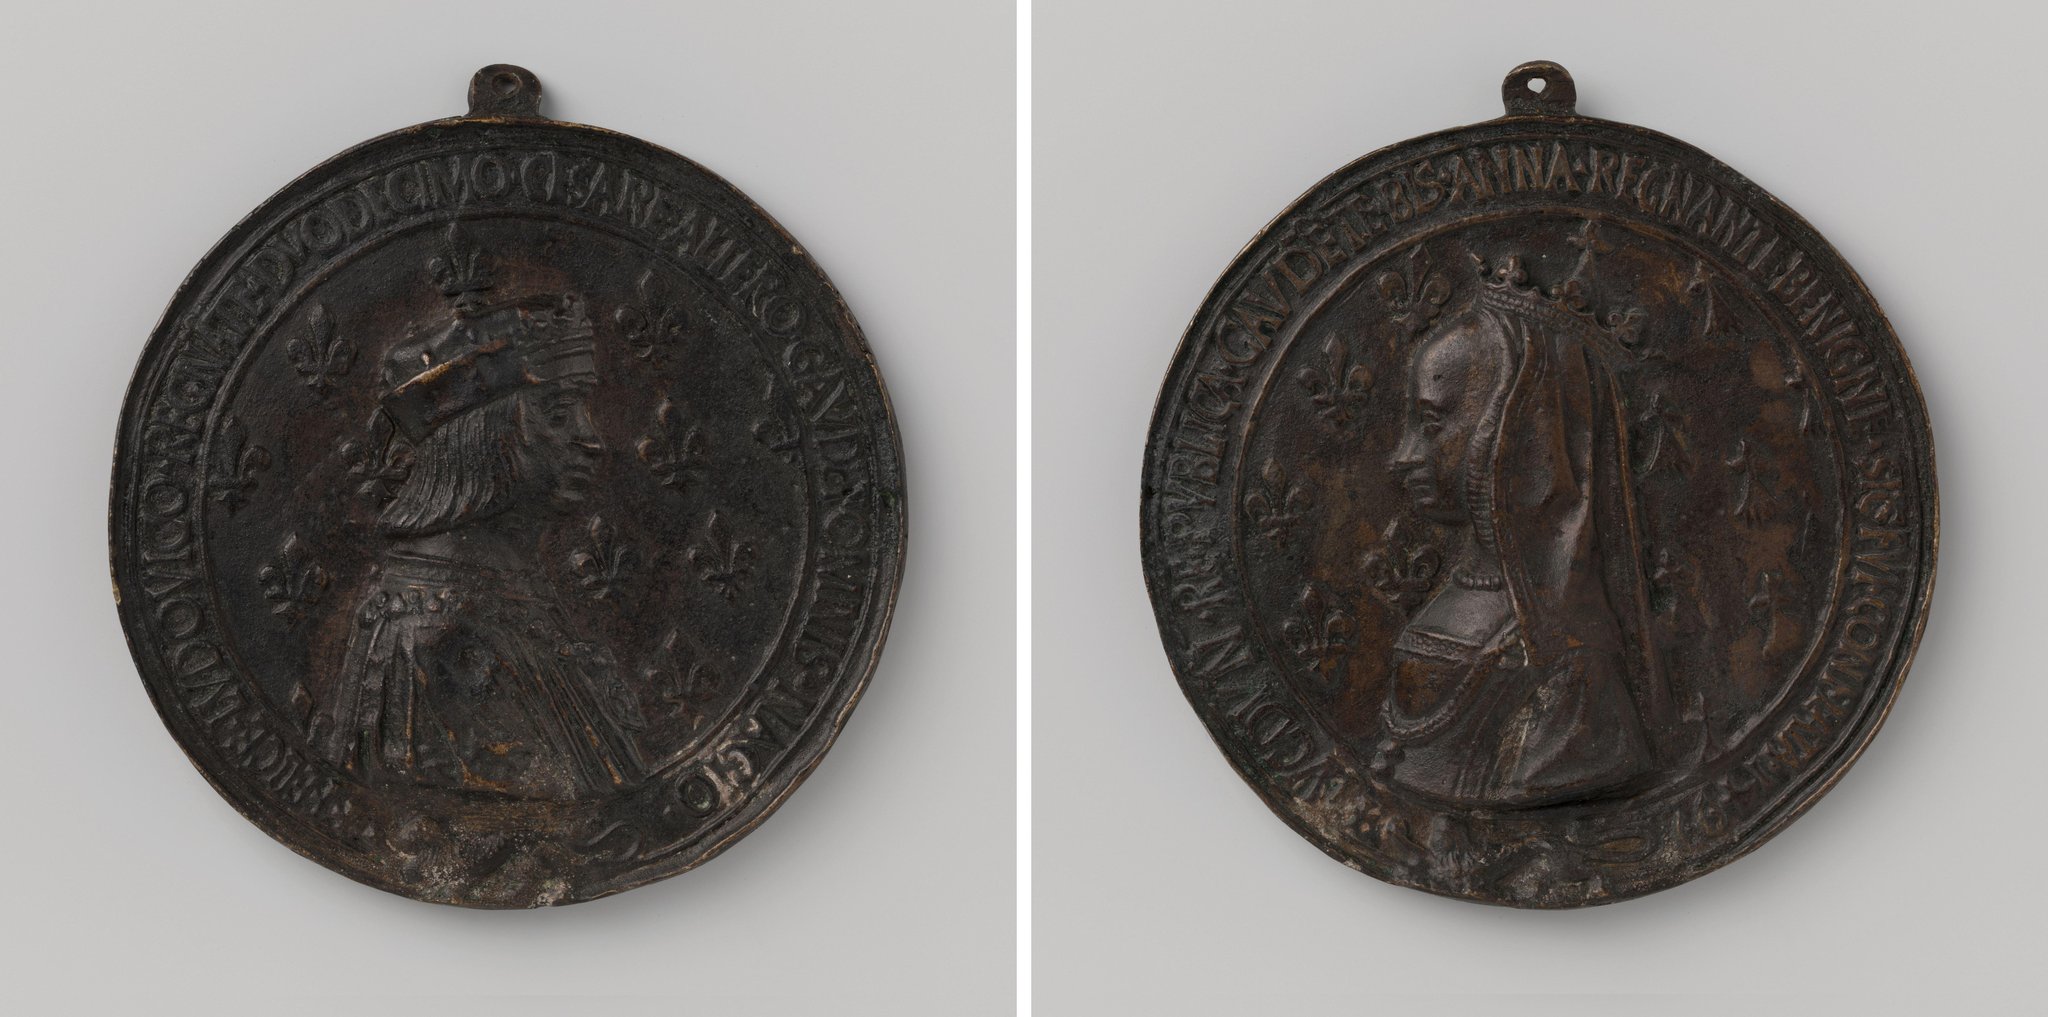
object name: copy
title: Lodewijk XII van Frankrijk en Anna van Bretagne, penning geslagen ter ere van hun bezoek aan de stad Lyon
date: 1500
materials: bronze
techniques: casting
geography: lyon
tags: paris, lyon